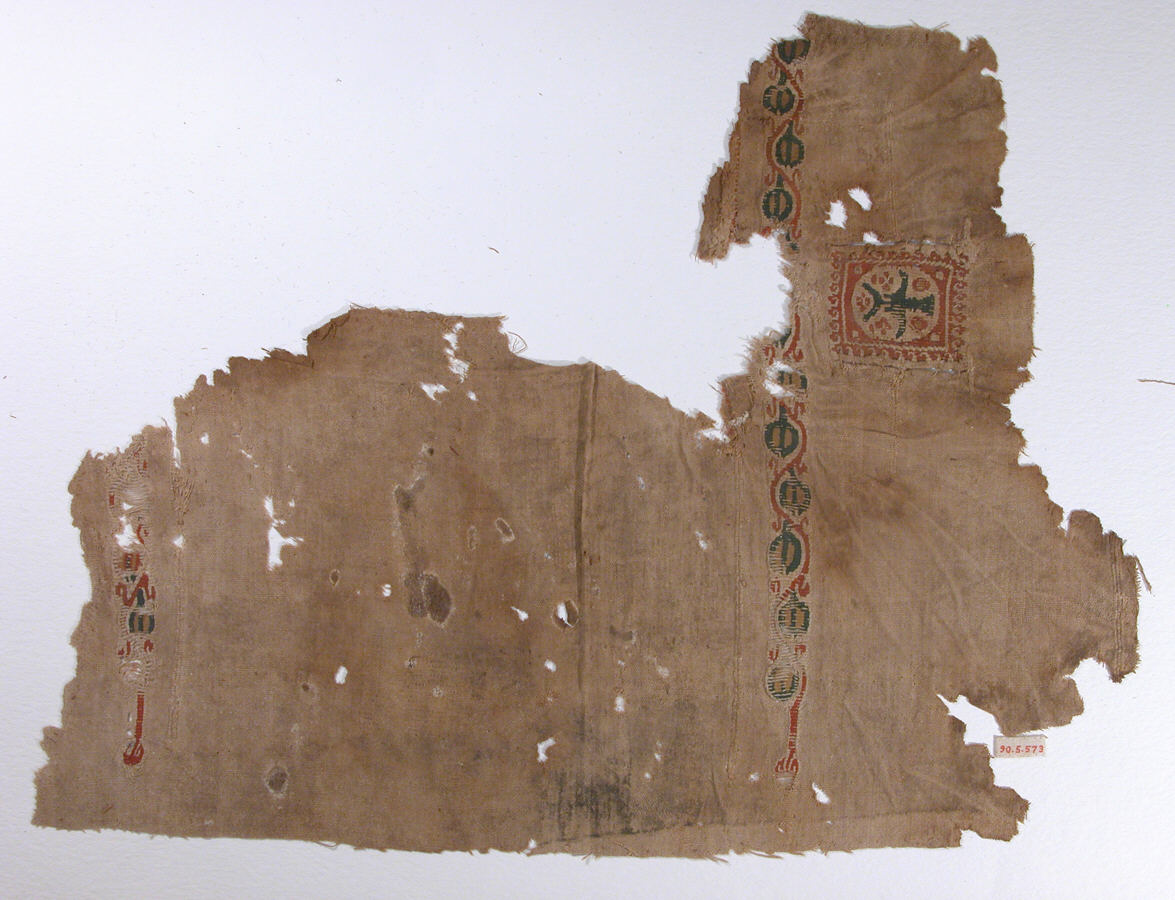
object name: textile fragment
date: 401-500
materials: linen, wool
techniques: weave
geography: egypt